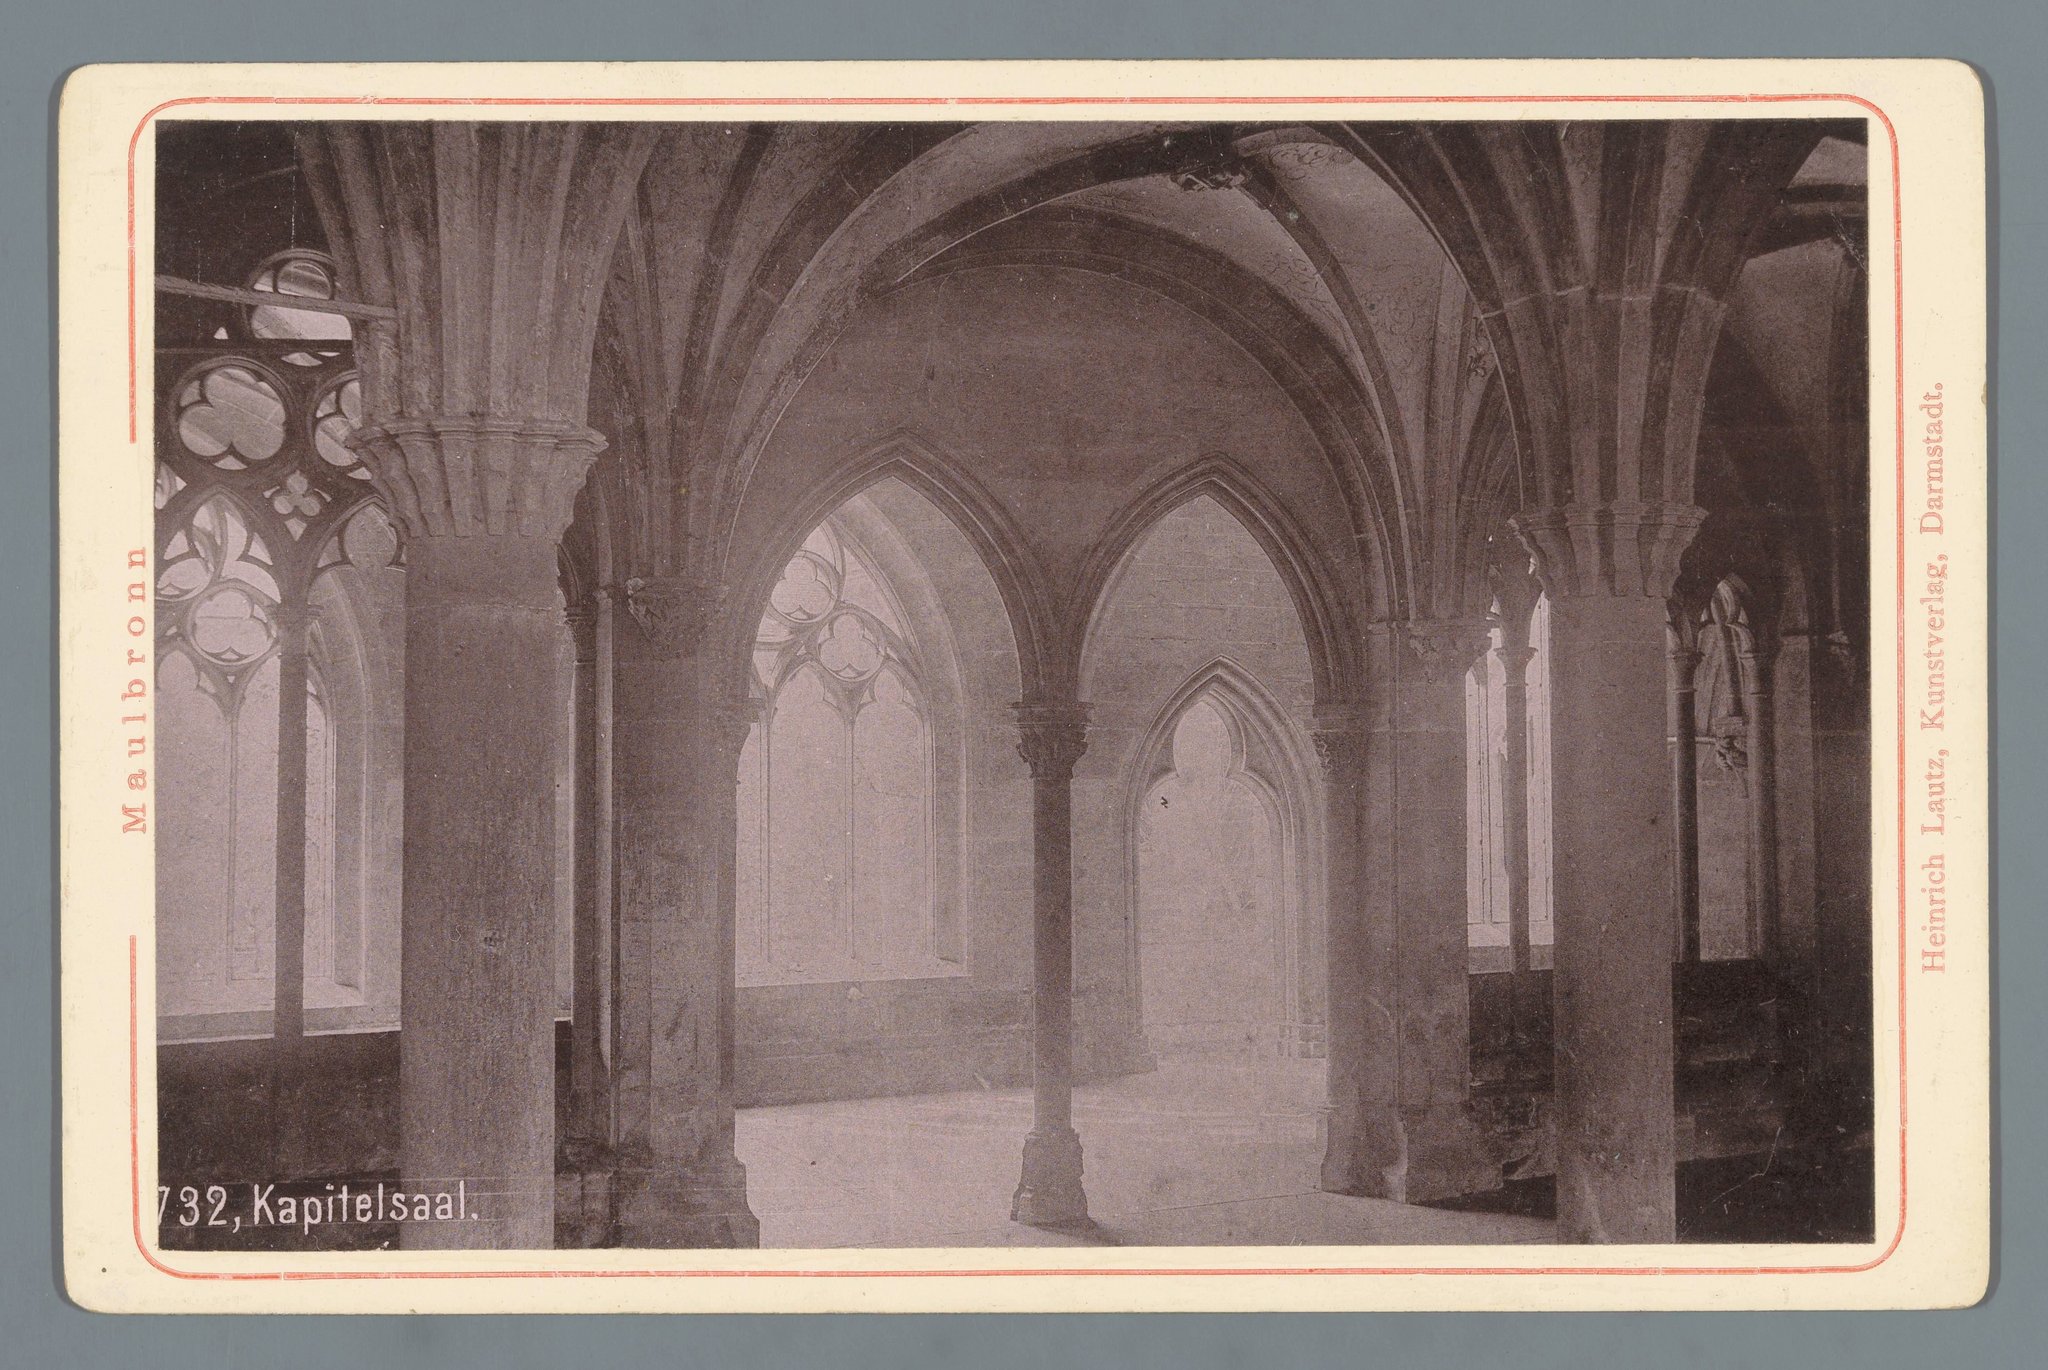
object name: photomechanical print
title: Maulbronn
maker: Anonymous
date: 1895-1900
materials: cardboard, paper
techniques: photograph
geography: maulbronn abbey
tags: abbey, monastery, convent ~ roman catholic church, interior ~ representation of a building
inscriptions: inscription: ‘17 Juli 1894.’, number: ‘732’